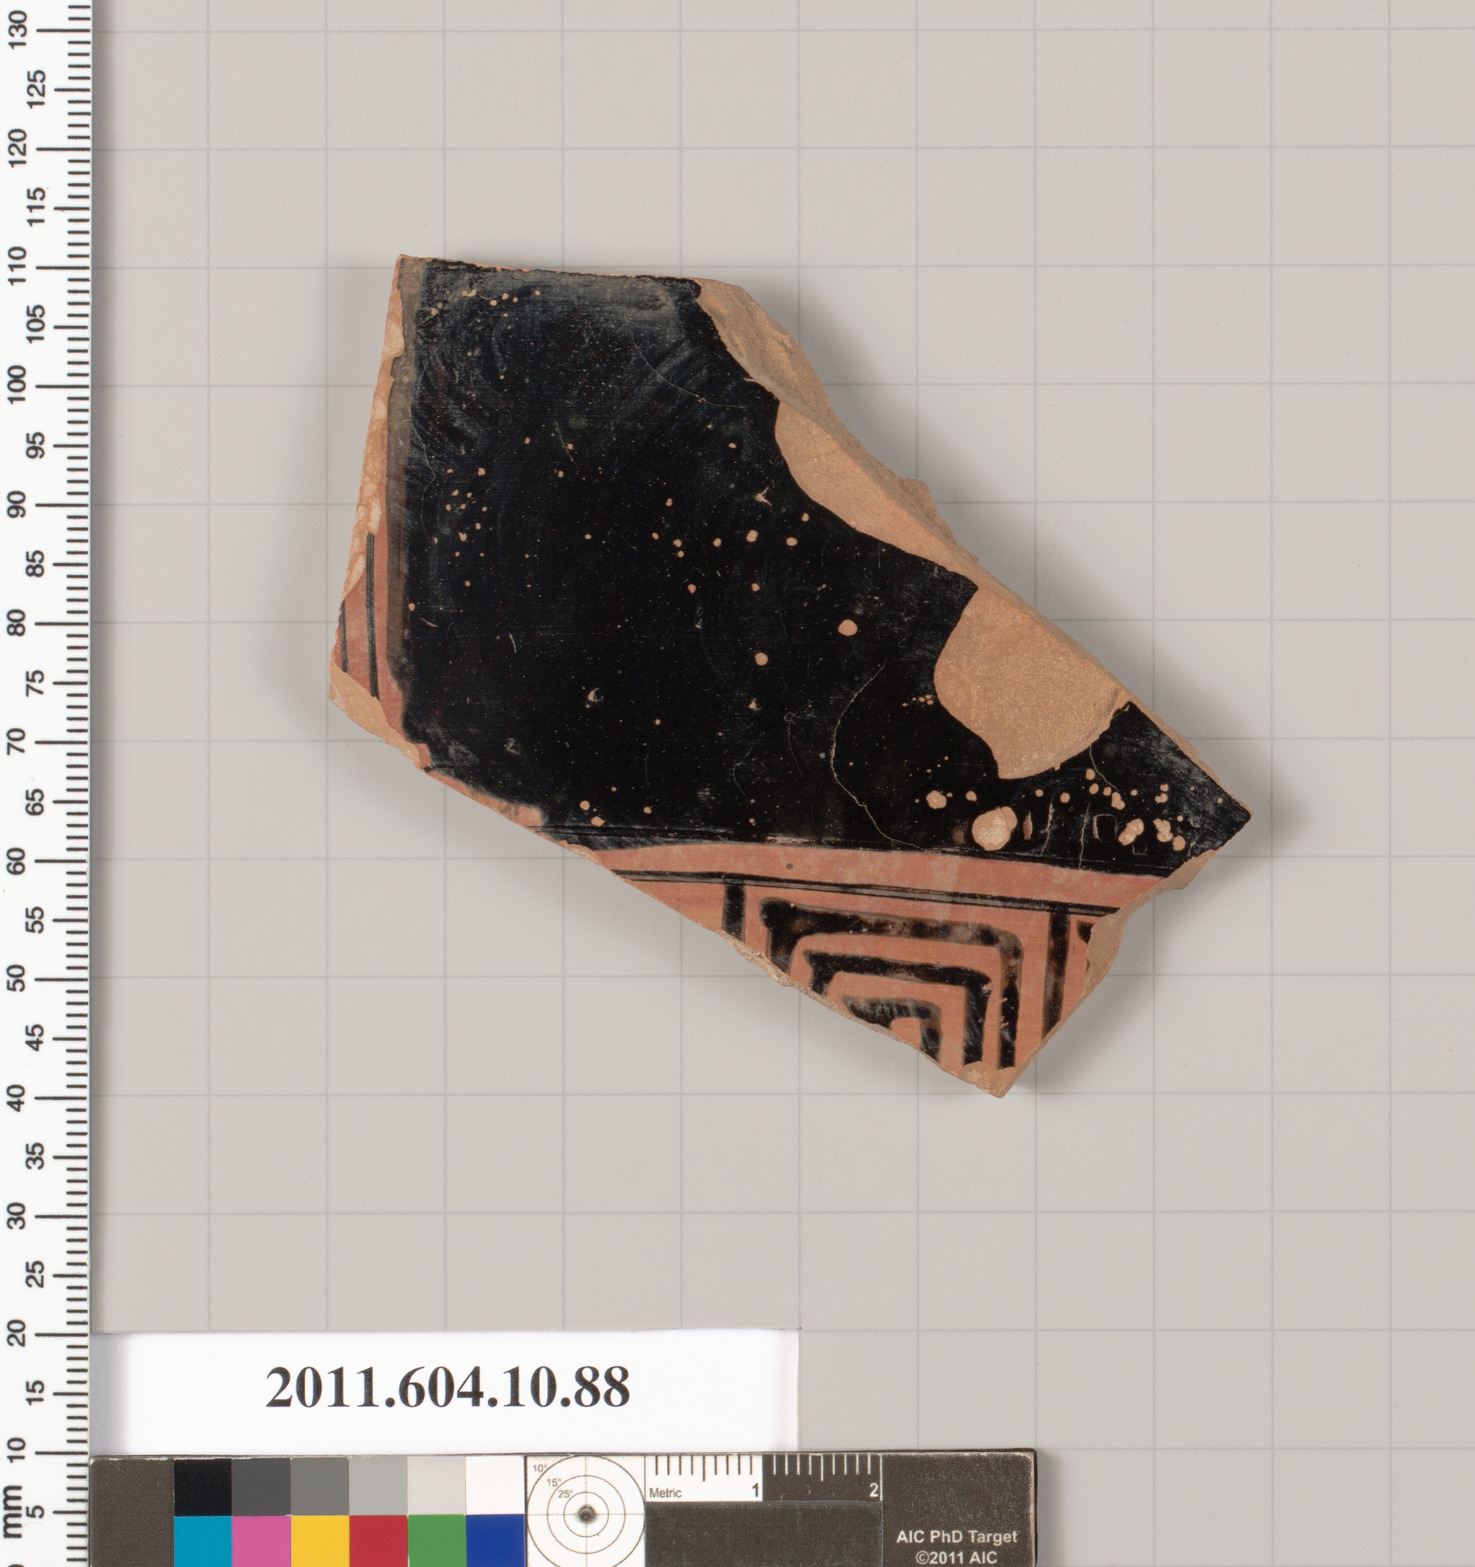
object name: undetermined closed shape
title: Terracotta fragment of a closed shape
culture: etruscan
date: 400-301 BCE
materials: terracotta